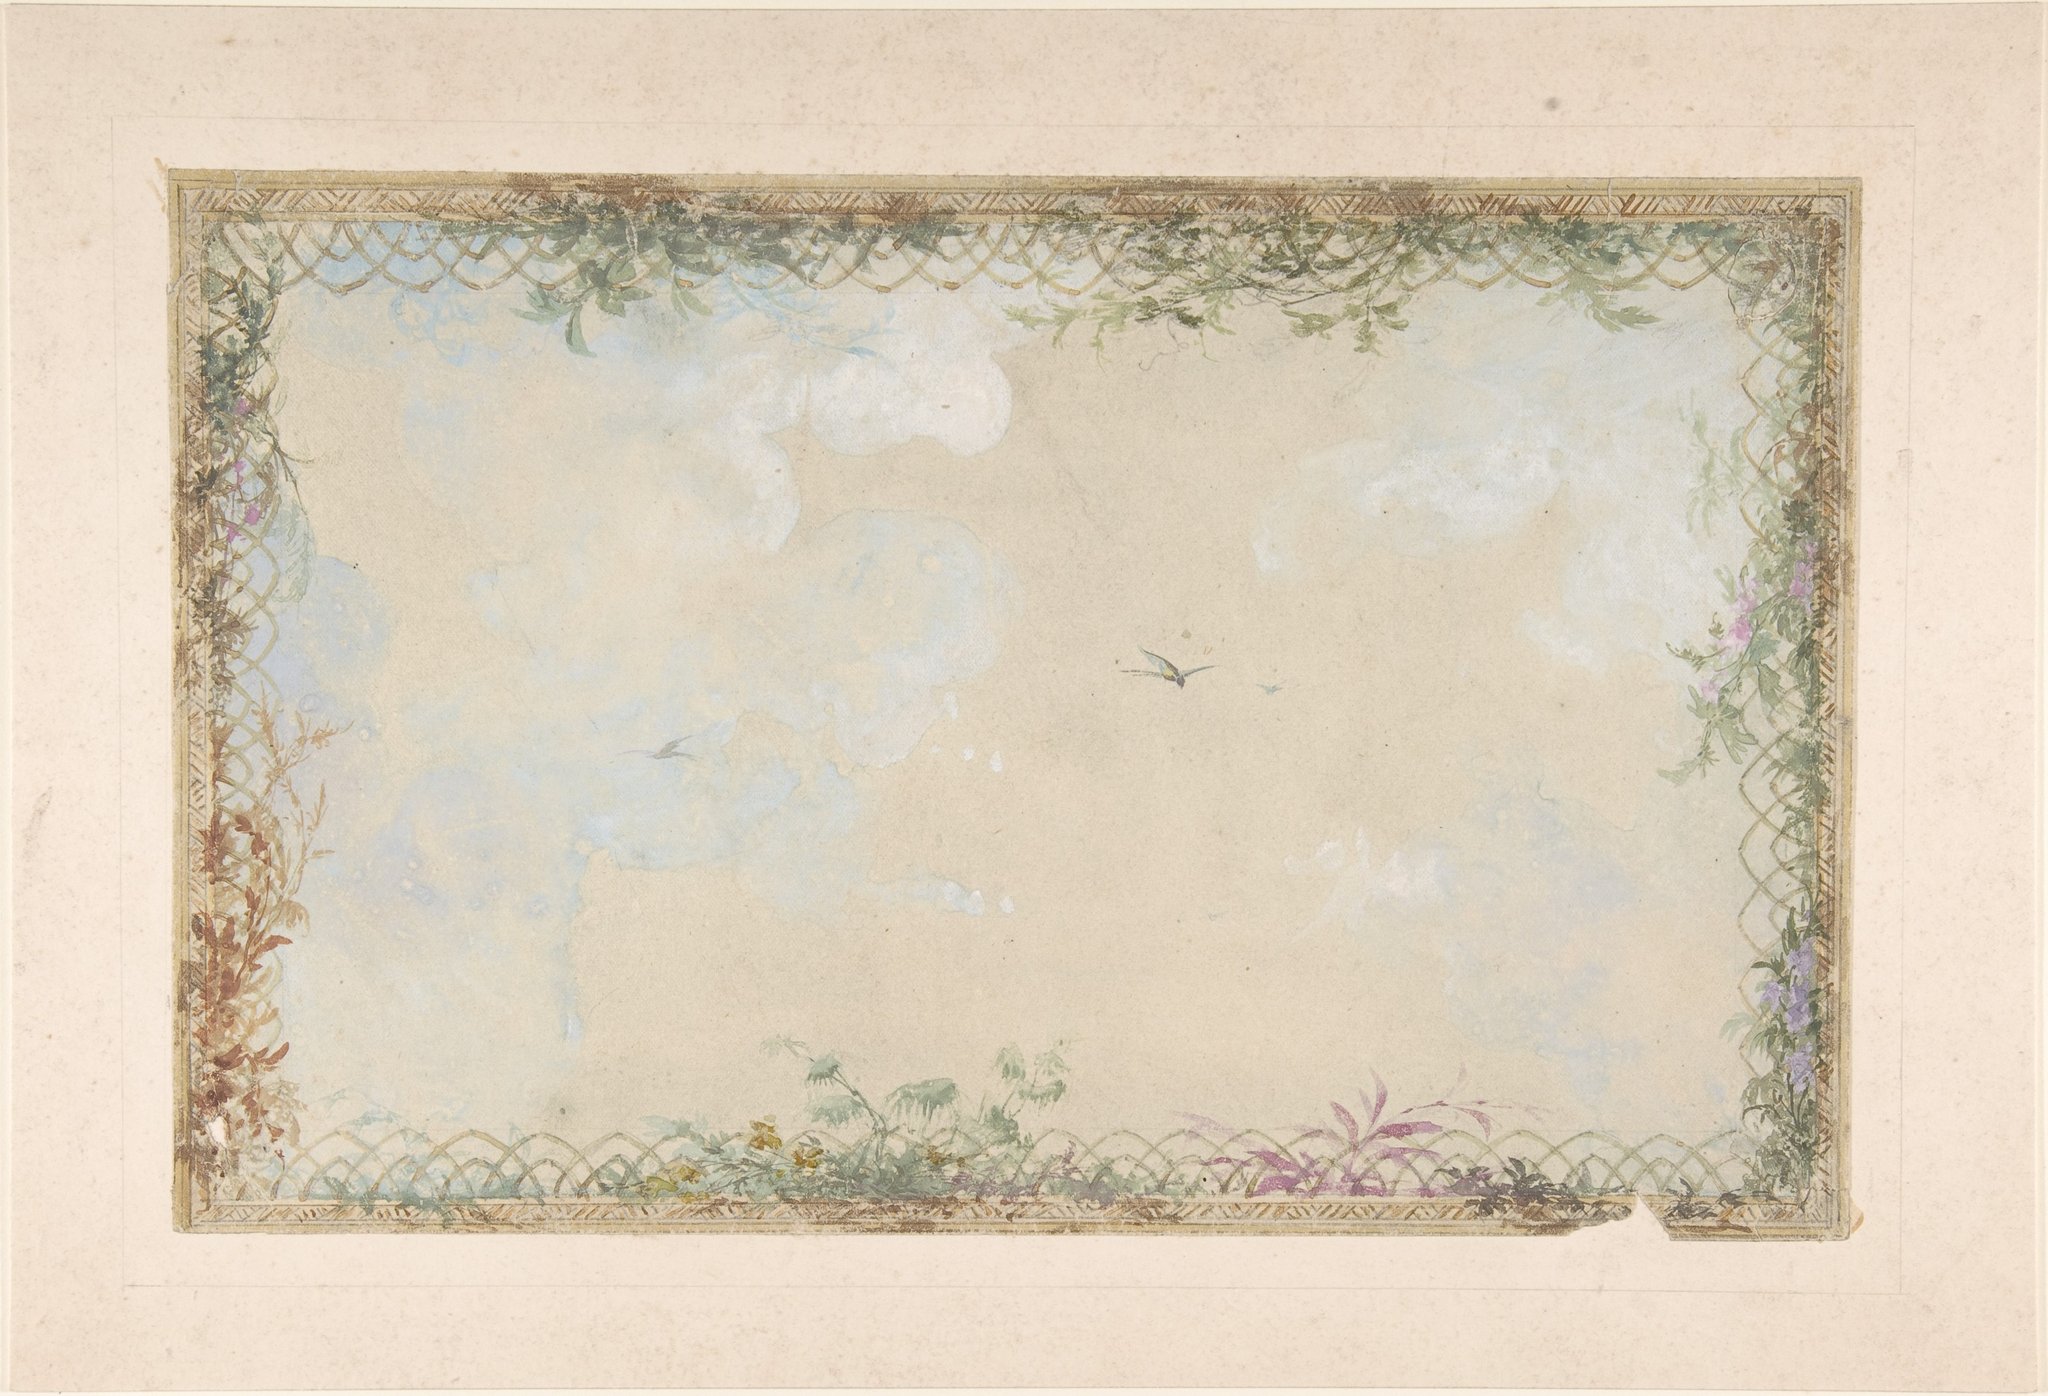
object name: drawing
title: Designs for Ceilings with Clouds and Birds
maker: charles monblond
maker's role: artist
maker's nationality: french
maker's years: 1800-1900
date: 1801-1900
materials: graphite, watercolor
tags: clouds,ceilings